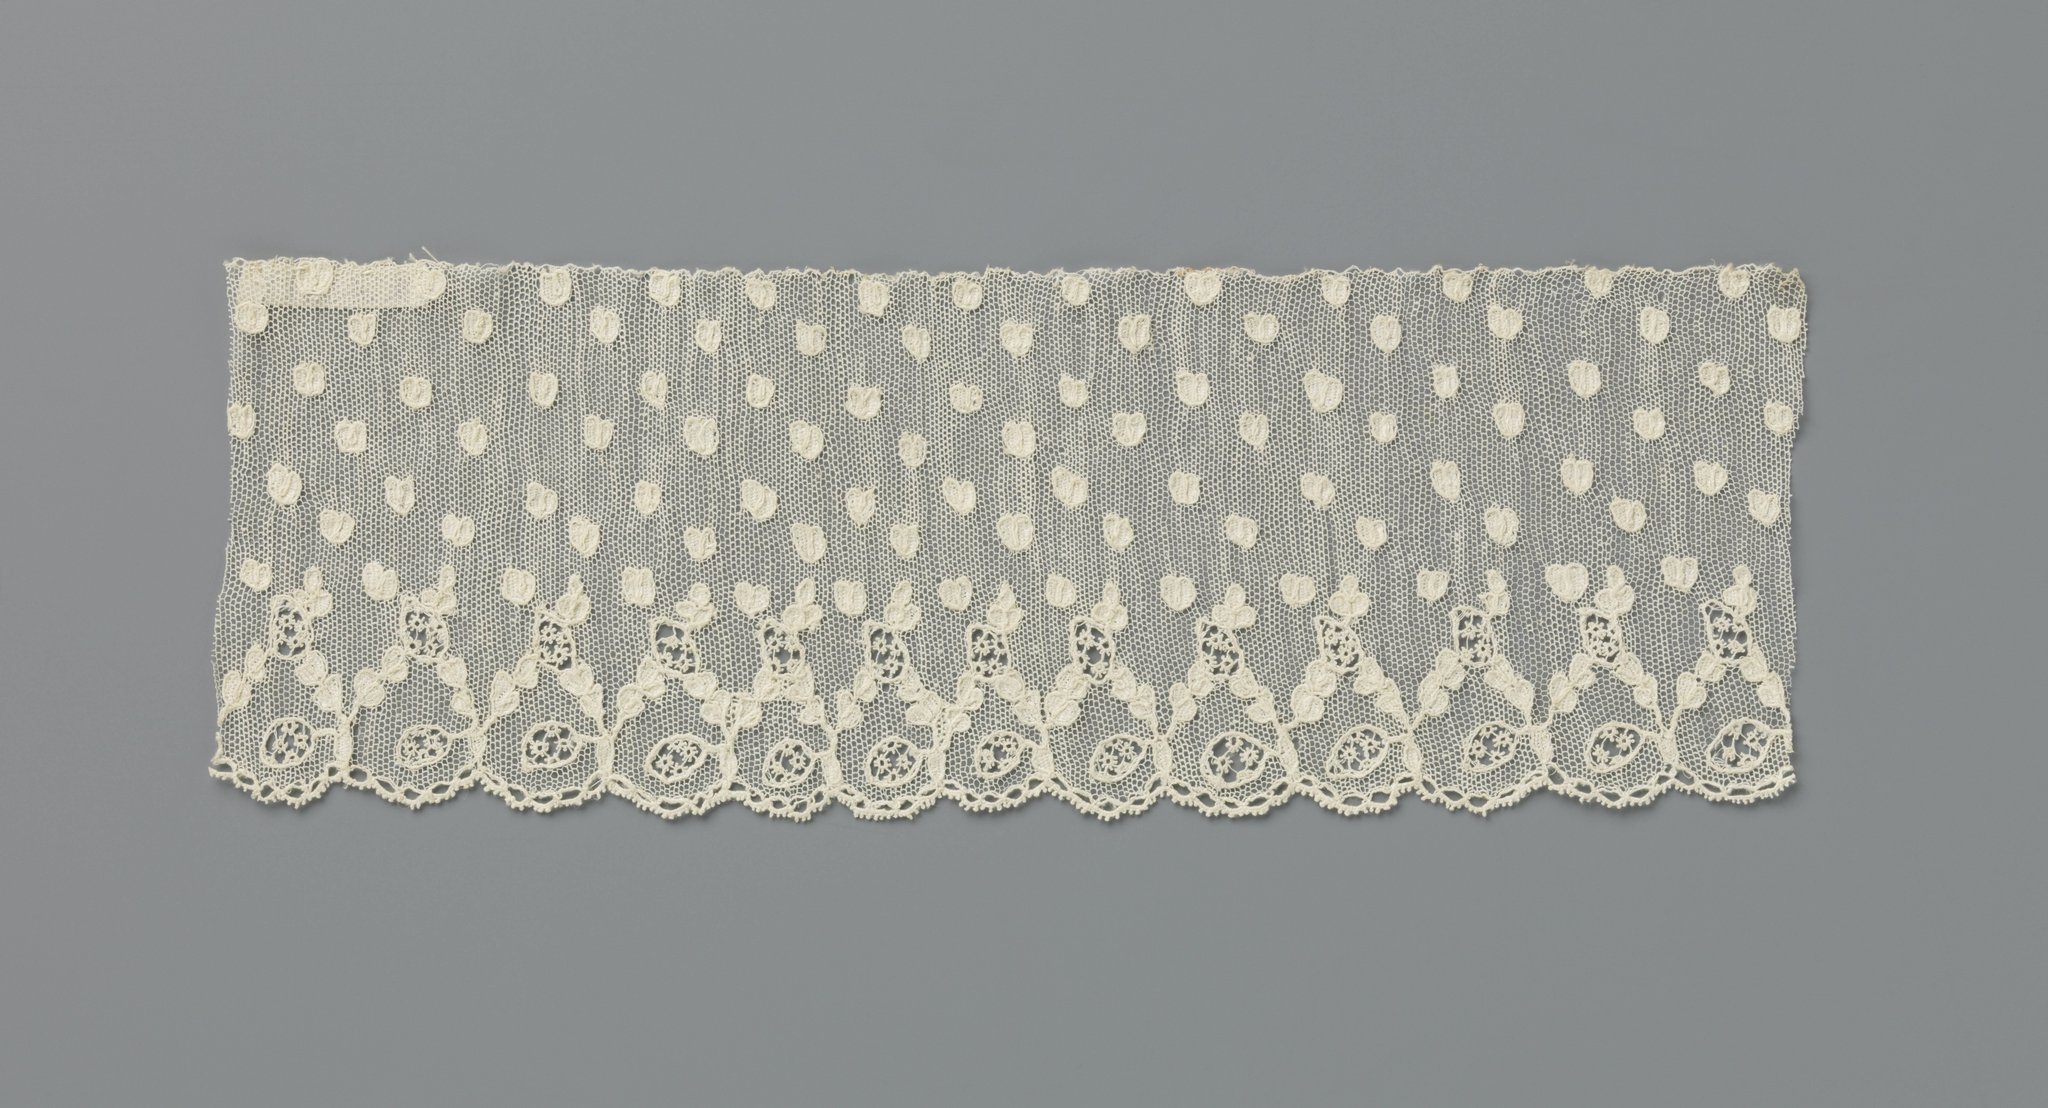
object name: strip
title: Strook naaldkant met hartvormige moesjes en aaneengeschakelde ovalen langs de onderzijde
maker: Anonymous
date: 1900-1915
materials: cotton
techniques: lace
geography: burano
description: Strook naturelkleurige naaldkant: Alençon-kant. Patroon met zeven rijen hartvormige moesjes en aaneengeschakelde ovale cartouches langs de onderzijde. De ovalen worden elk bekroond door een opengewerkt ovaal en met raderpicots erin. Zo'n zelfde opengewerkt ovaal bevind zich ook in het centrum van elk ovale cartouche en ontspringt steeds met een steeltje vanuit de rechterkant. De halfronde onderzijde van de cartouches worden gevormd door een rij aaneengeschakelde en opgewerkte ovaaltjes. De motieven zijn gemaakt met festonsteken en voorzien van reliëfcontouren. De motieven zijn met elkaar verbonden door een fijne maasgrond. De bovenzijde van de strook is recht afgewerkt. De schulpenrand met halfronde schulpen komt voort uit het patroon en is afgewerkt met picots.